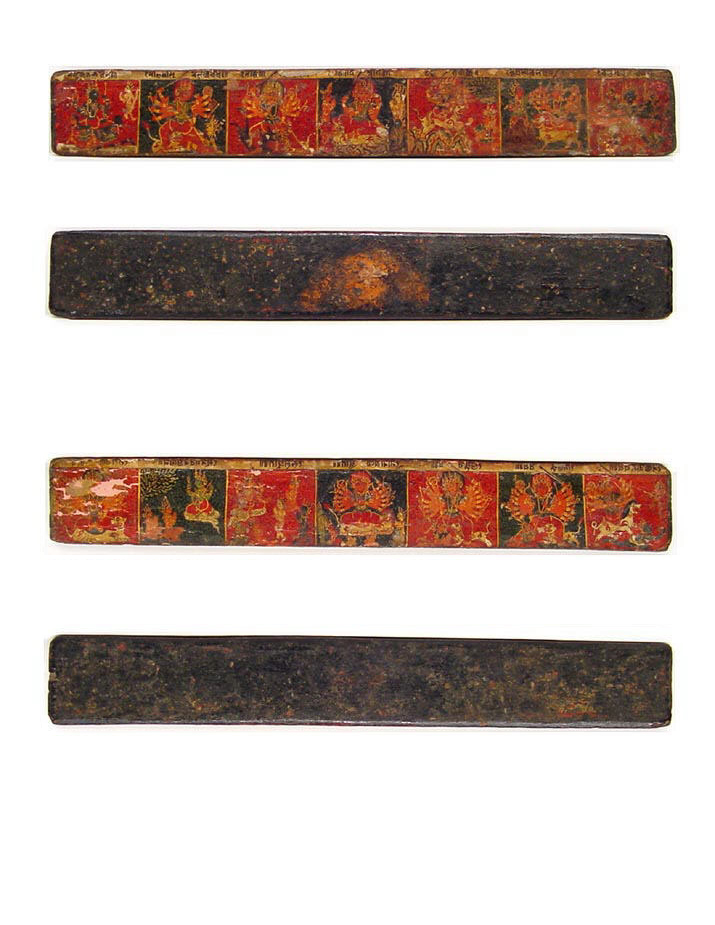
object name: book cover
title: Pair of Book Covers with Scenes from the Devimahatmya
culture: nepali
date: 1601-1700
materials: wood